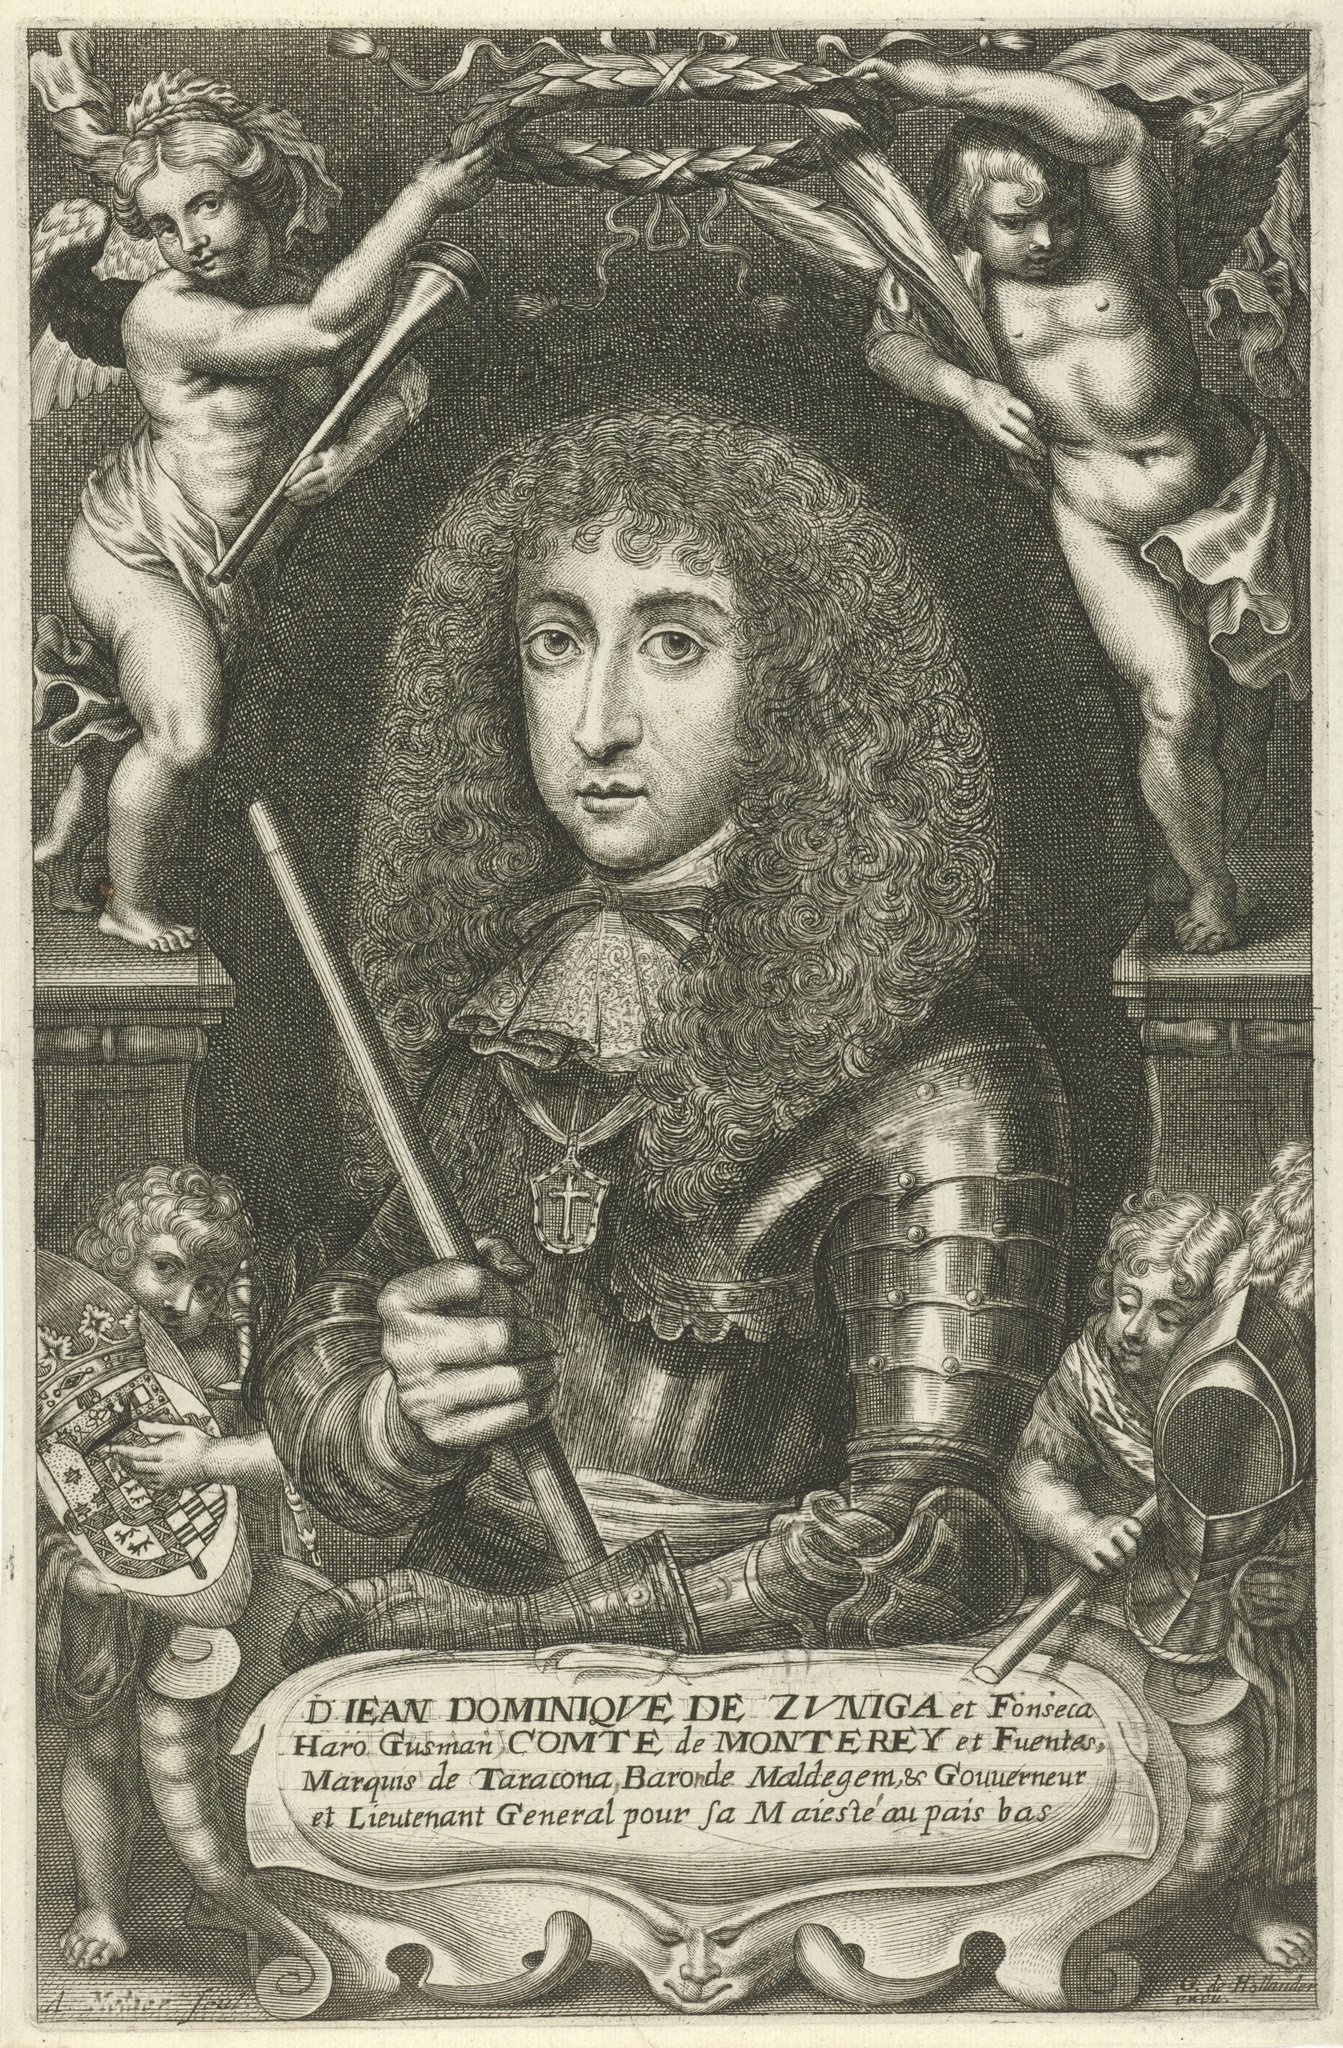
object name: print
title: Portret van Juan Domingo de Zuñiga y Fonseca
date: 1645-1668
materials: paper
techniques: engraving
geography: antwerp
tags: juan domingo méndez de haro y fernández de córdoba, baton of general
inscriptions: collector's mark: Lugt 2228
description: Portret van veldheer Juan Domingo de Zuñiga y Fonseca, gekleed in harnas, met een bevelhebberstaf in zijn hand. Twee engelen kronen hem met een lauwerkrans. Linksonder draagt een putto zijn wapenschild en rechtsonder draagt een putto een helm.